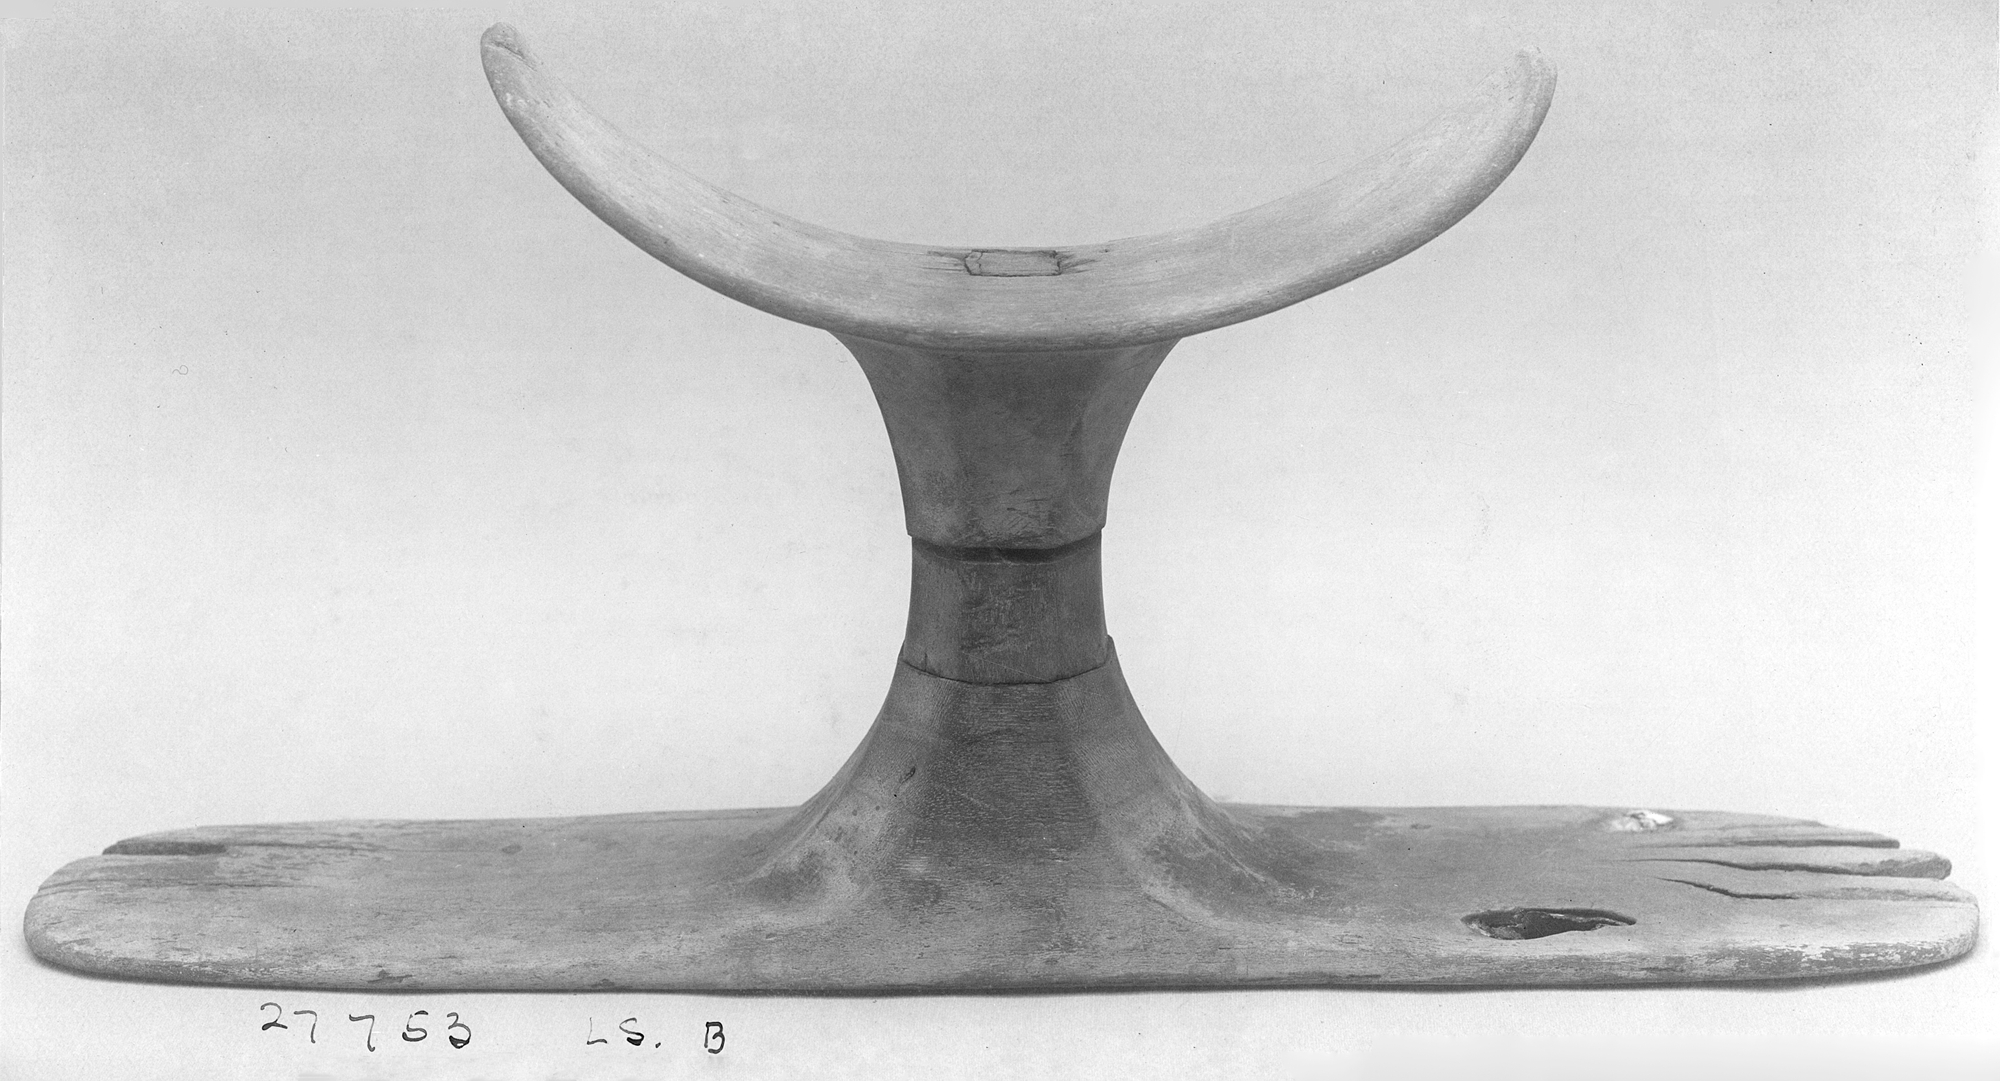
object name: headrest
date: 1580-1479 BCE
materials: wood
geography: egypt